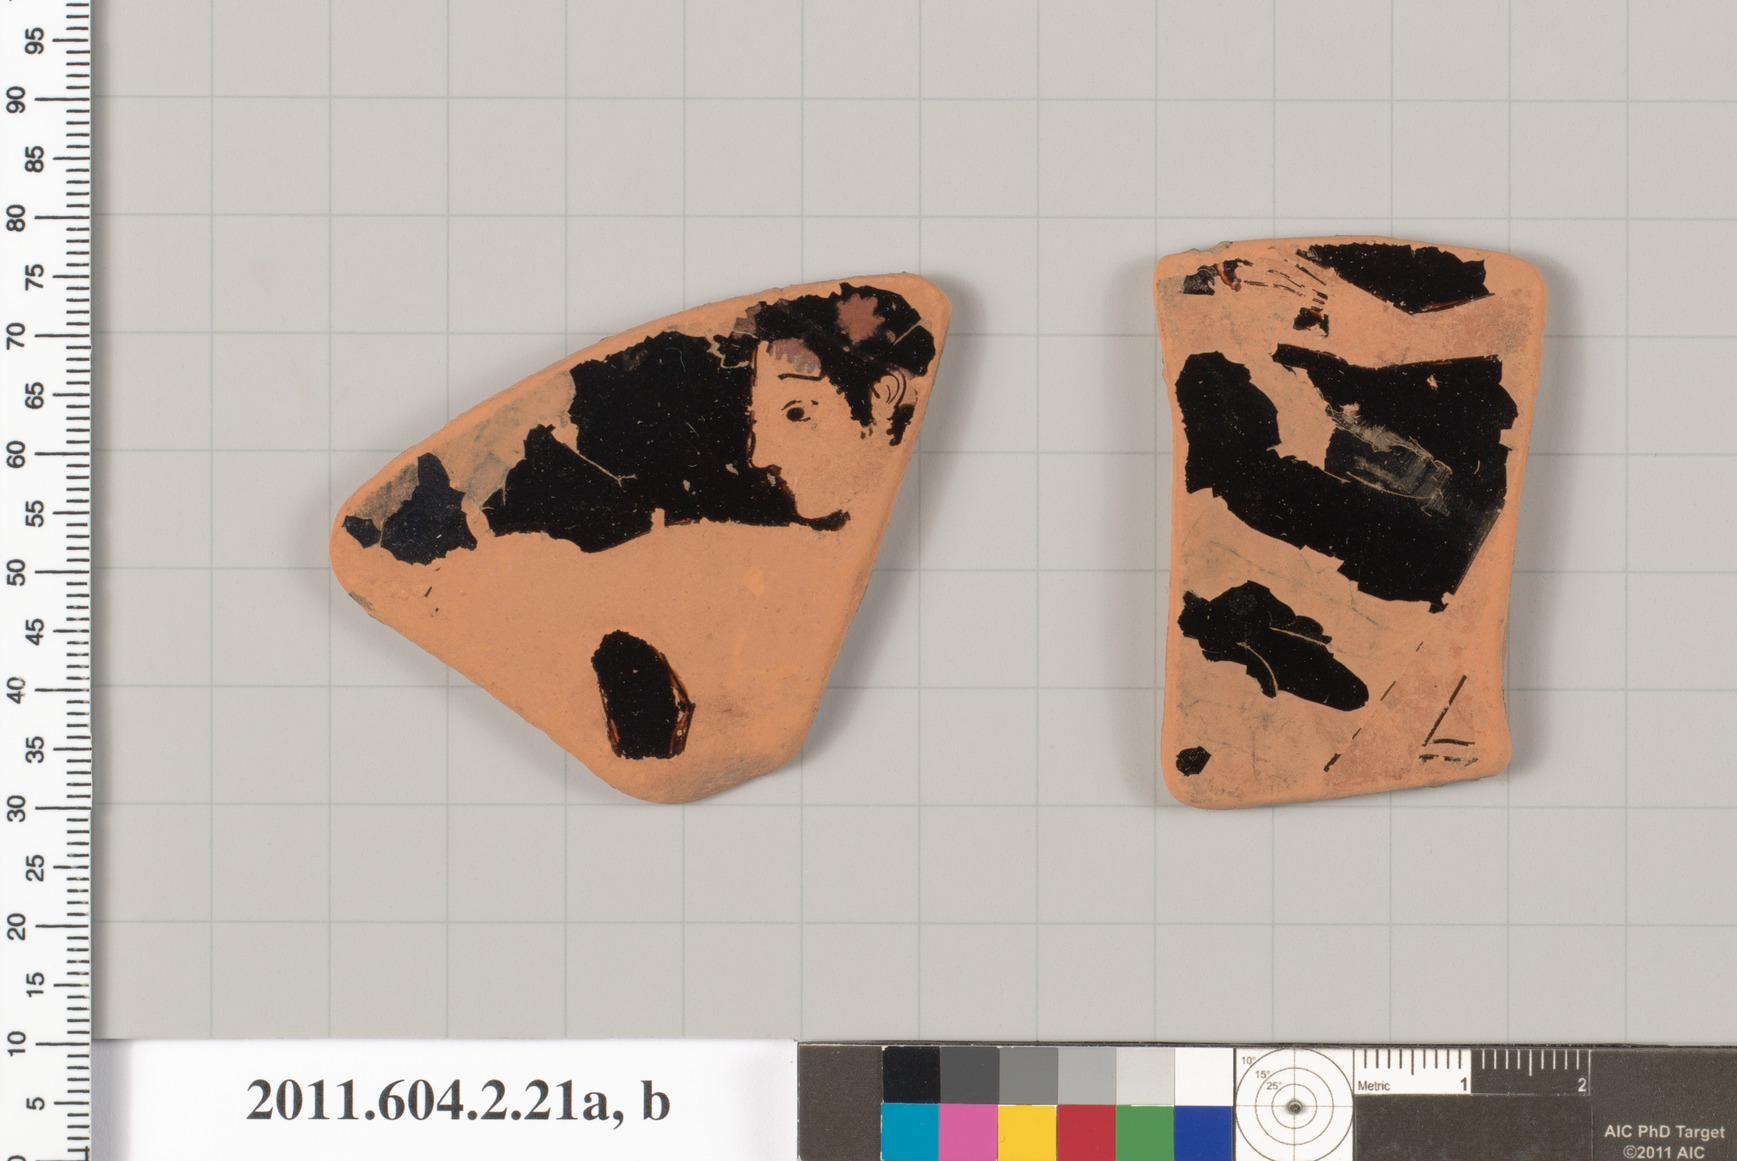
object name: psykter fragment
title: Terracotta fragments of a psykter (vase for cooling wine)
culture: greek, attic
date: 520-500 BCE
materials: terracotta